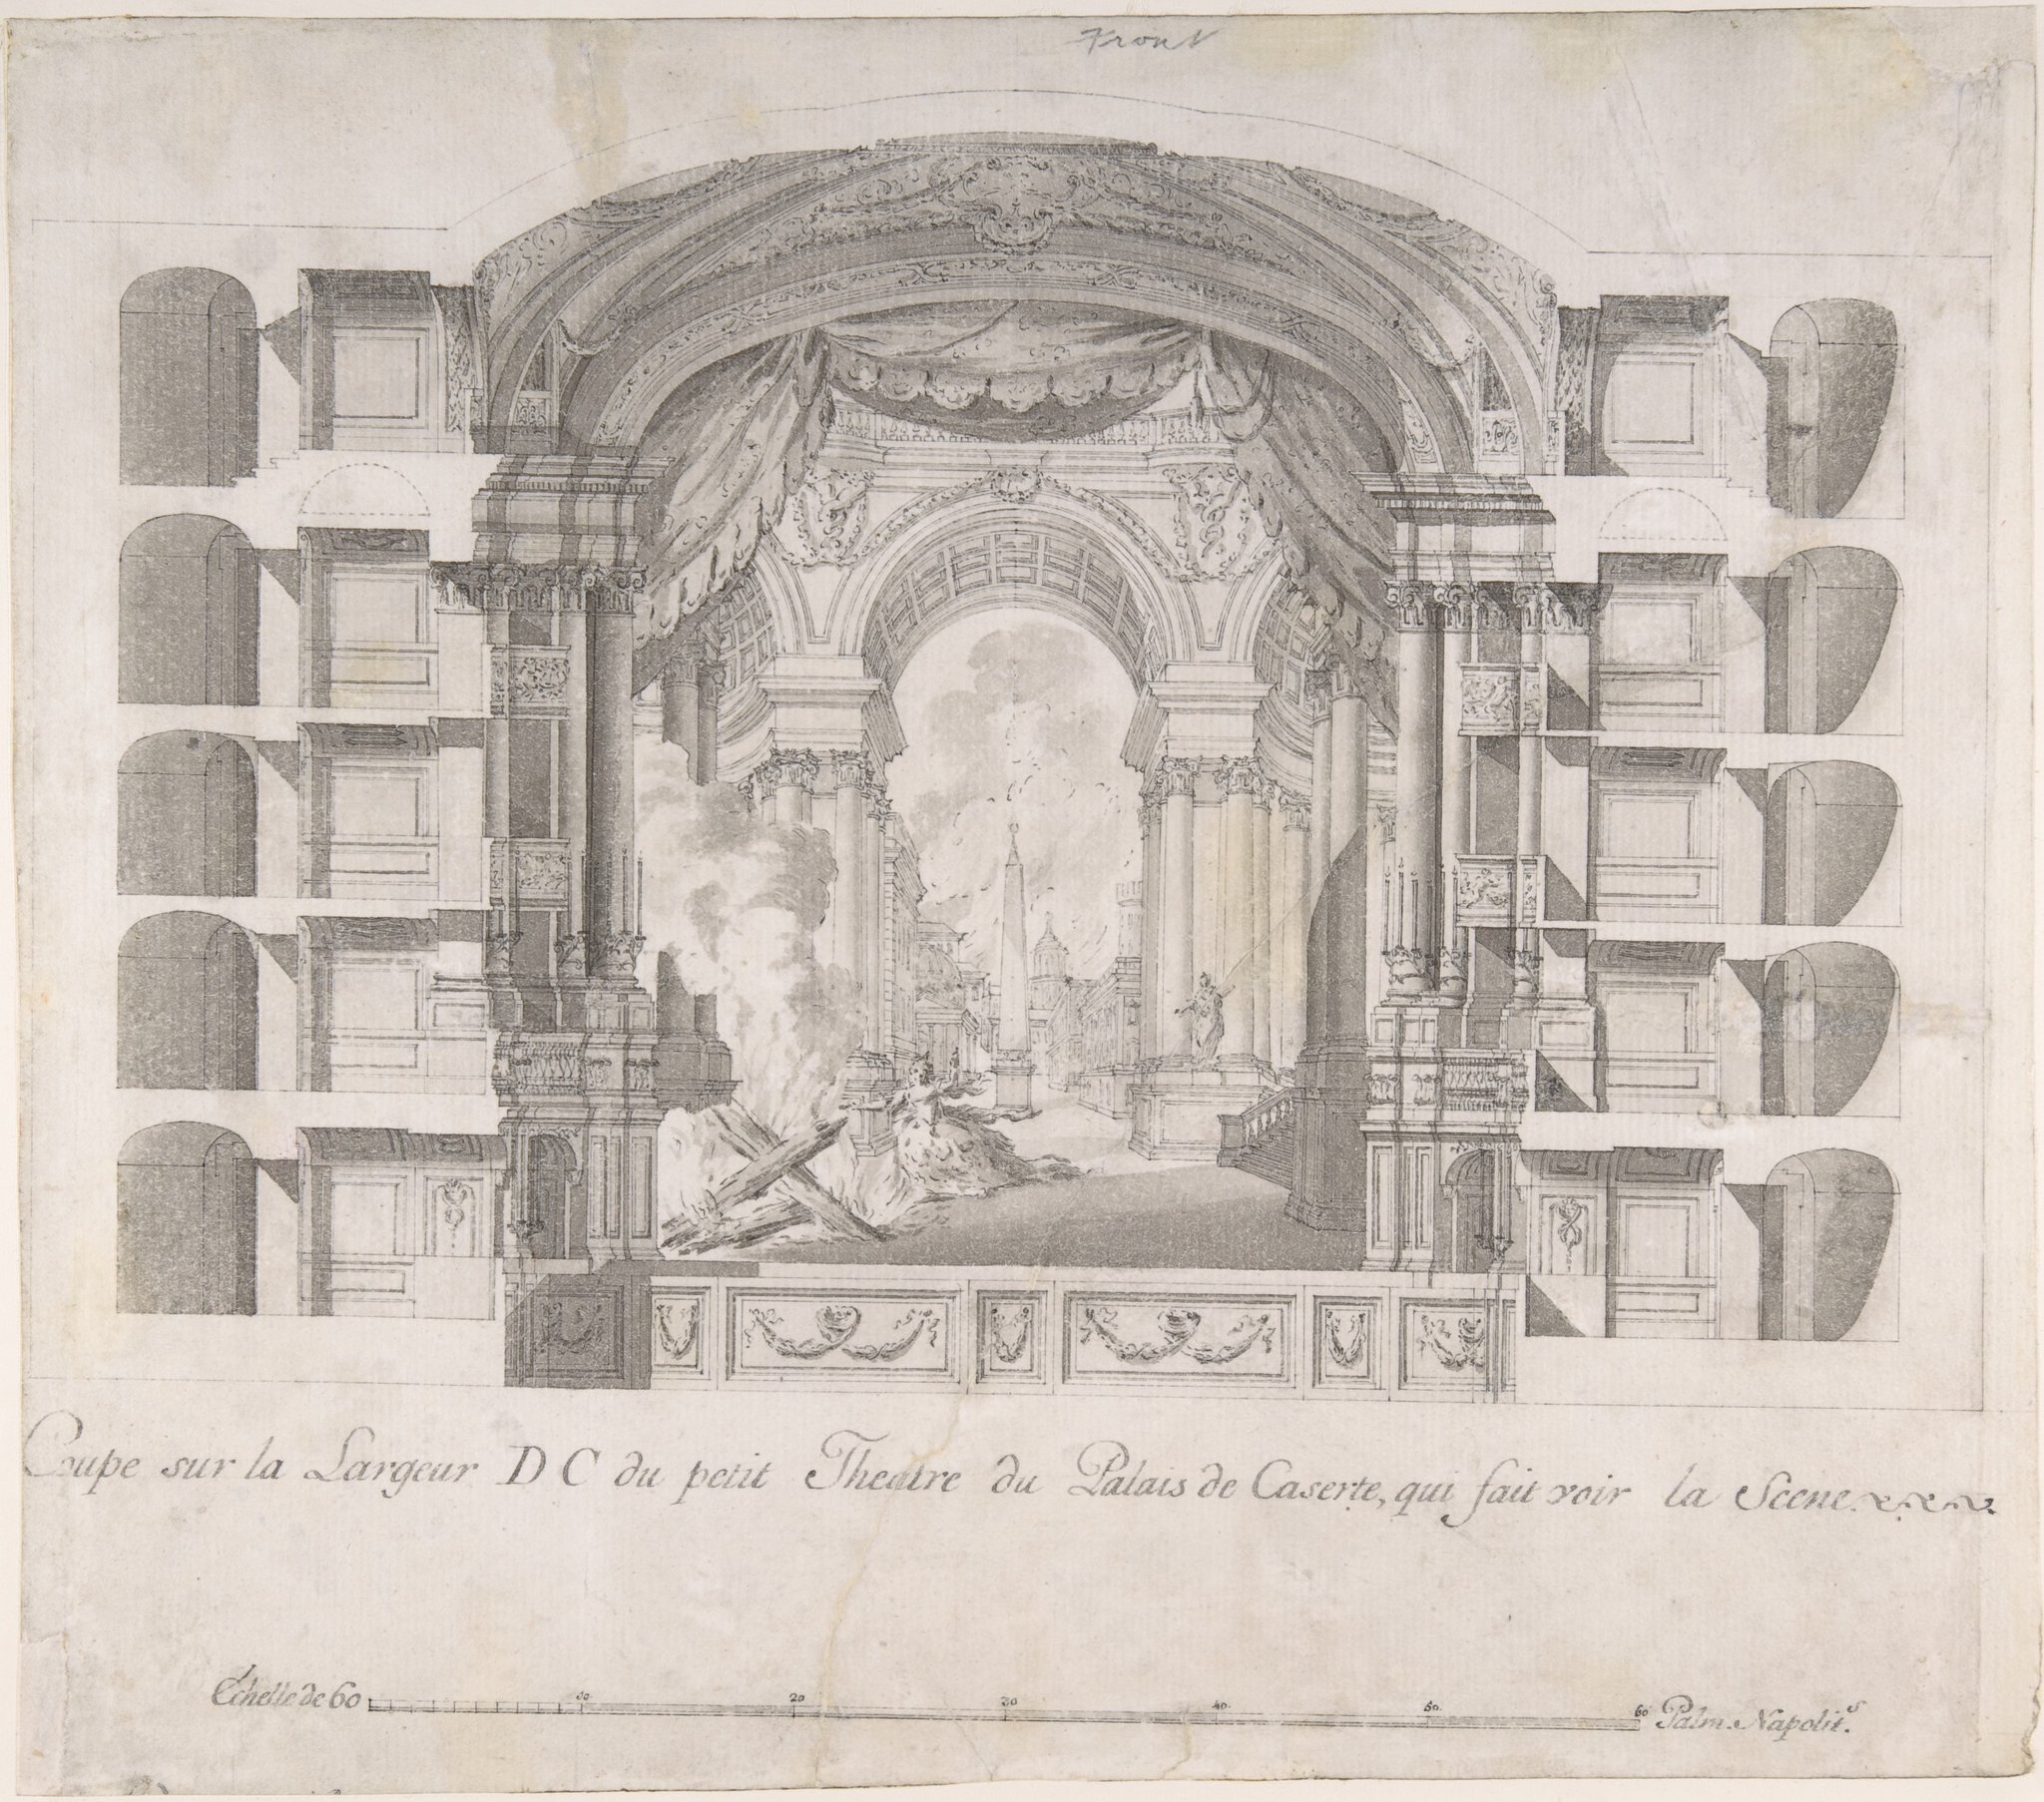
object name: drawing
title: Transverse Section of the Small Theater at the Palace of Caserta, with a View of a Stage Design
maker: luigi vanvitelli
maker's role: artist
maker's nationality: italian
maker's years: 1700-1773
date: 1700-1773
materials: graphite, ink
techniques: brush, pen, drawing, wash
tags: theatre,architecture